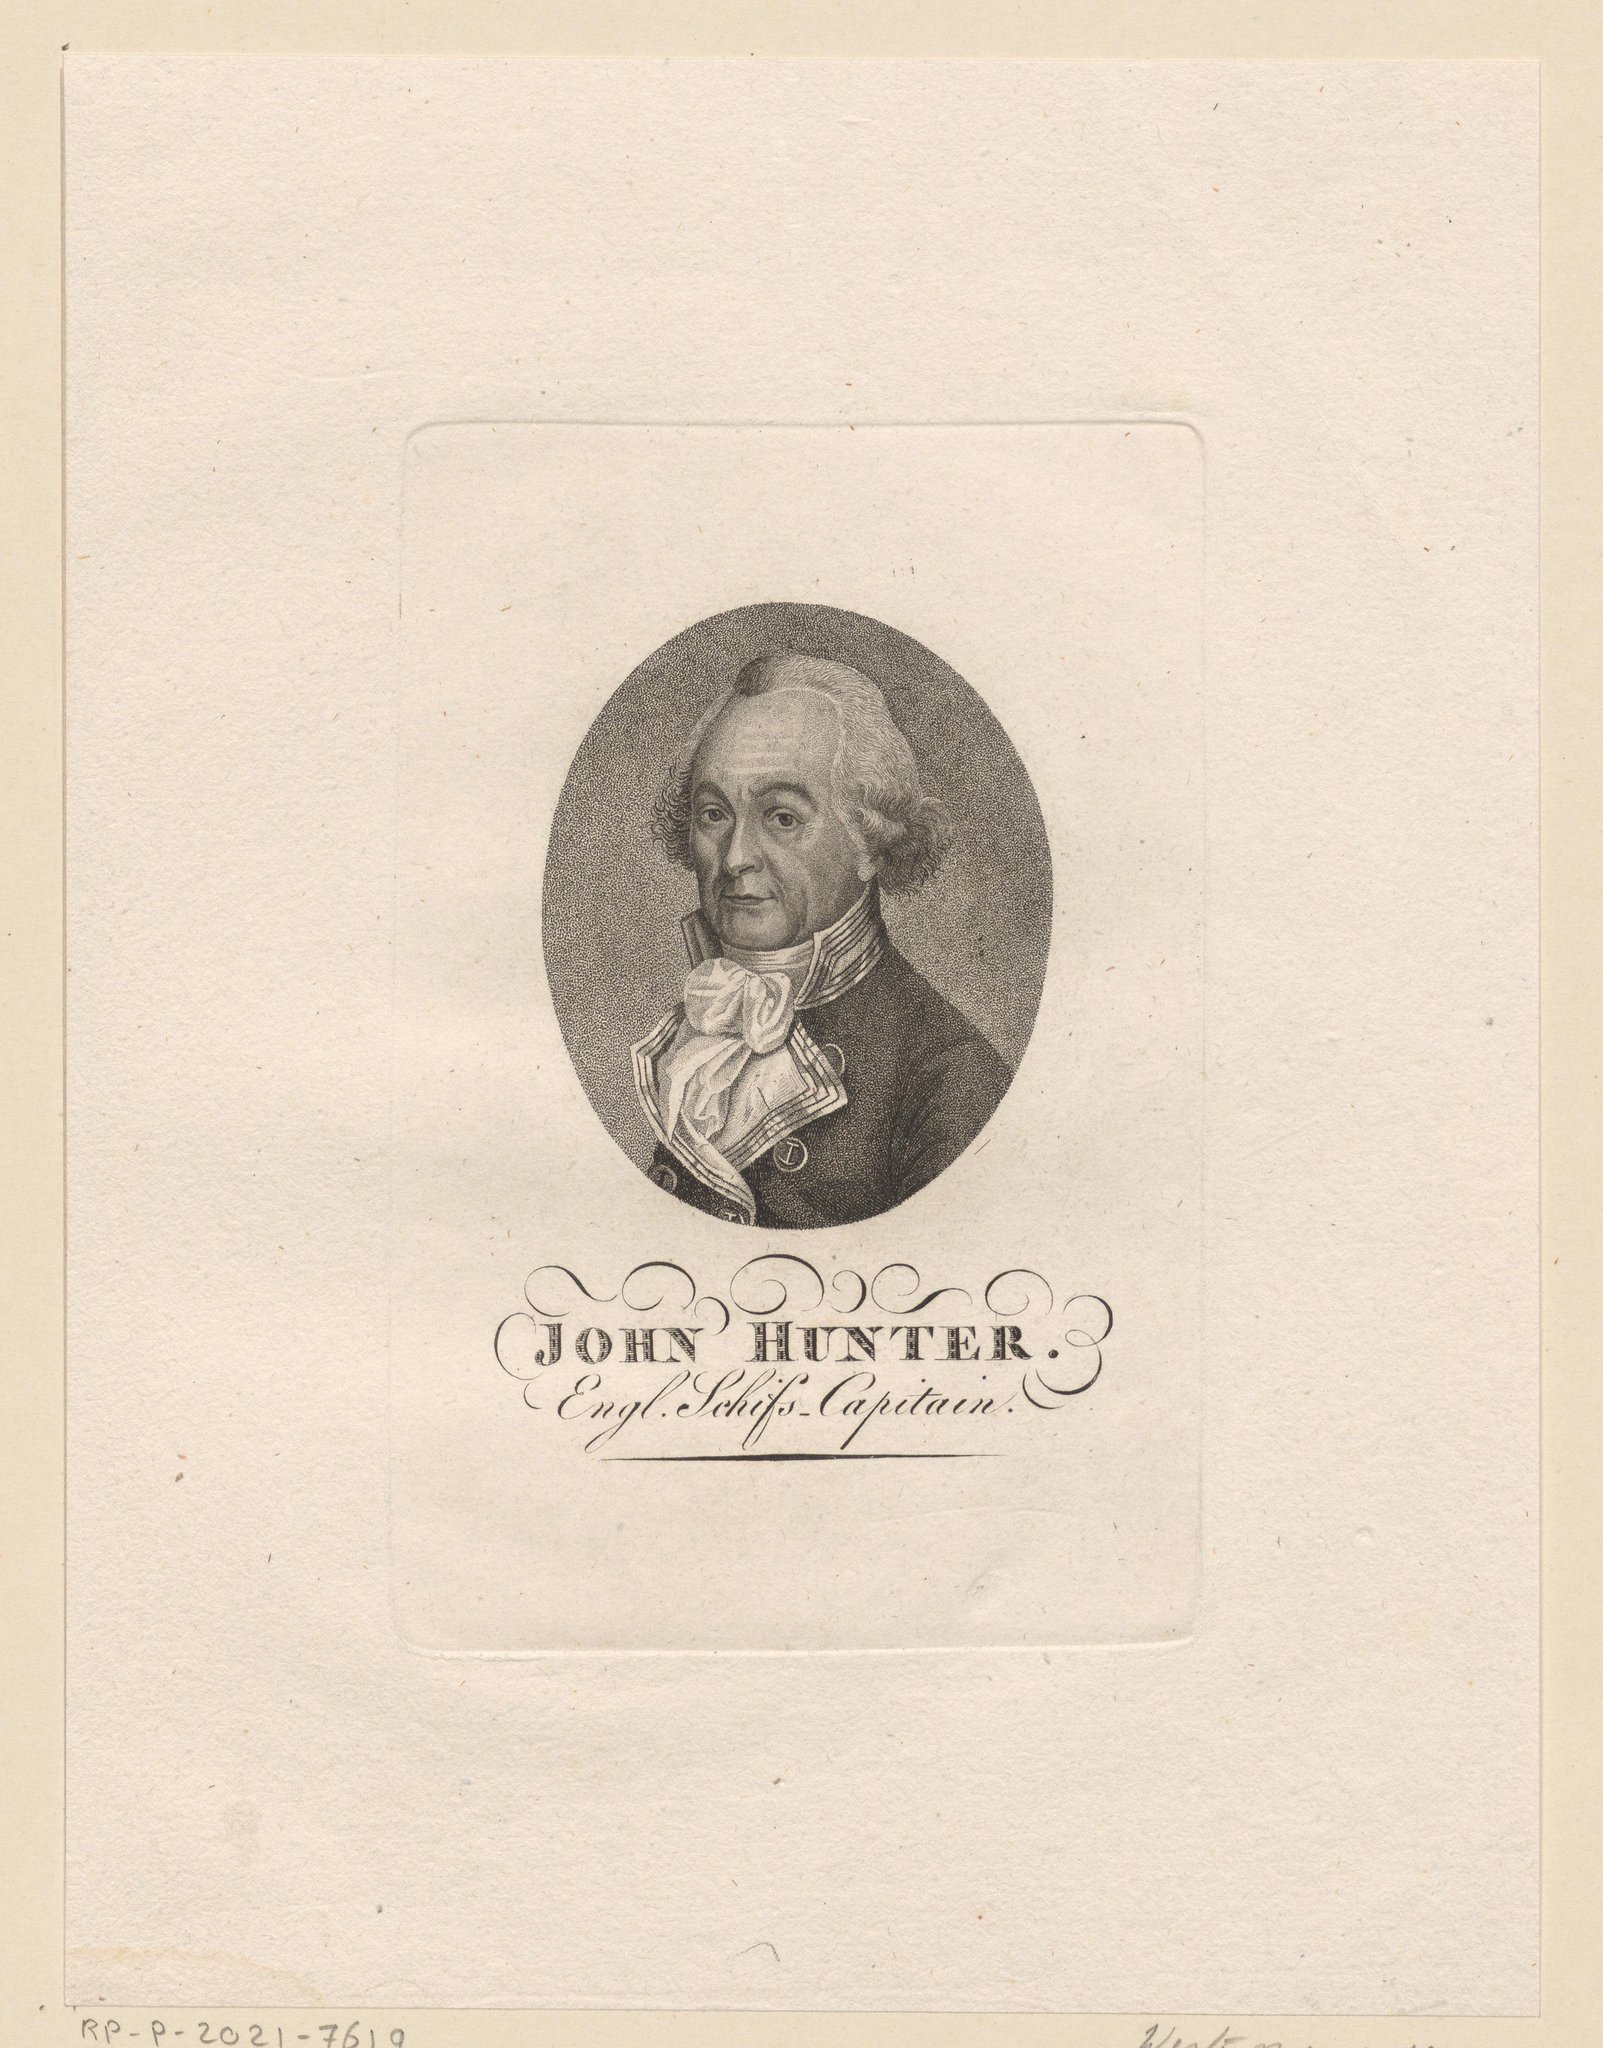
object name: print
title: Portret van John Hunter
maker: konrad westermayr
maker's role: print maker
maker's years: 1765-1834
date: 1786-1834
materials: paper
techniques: engraving, etching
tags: naval officer, john hunter, historical persons, commander-in-chief, admiral